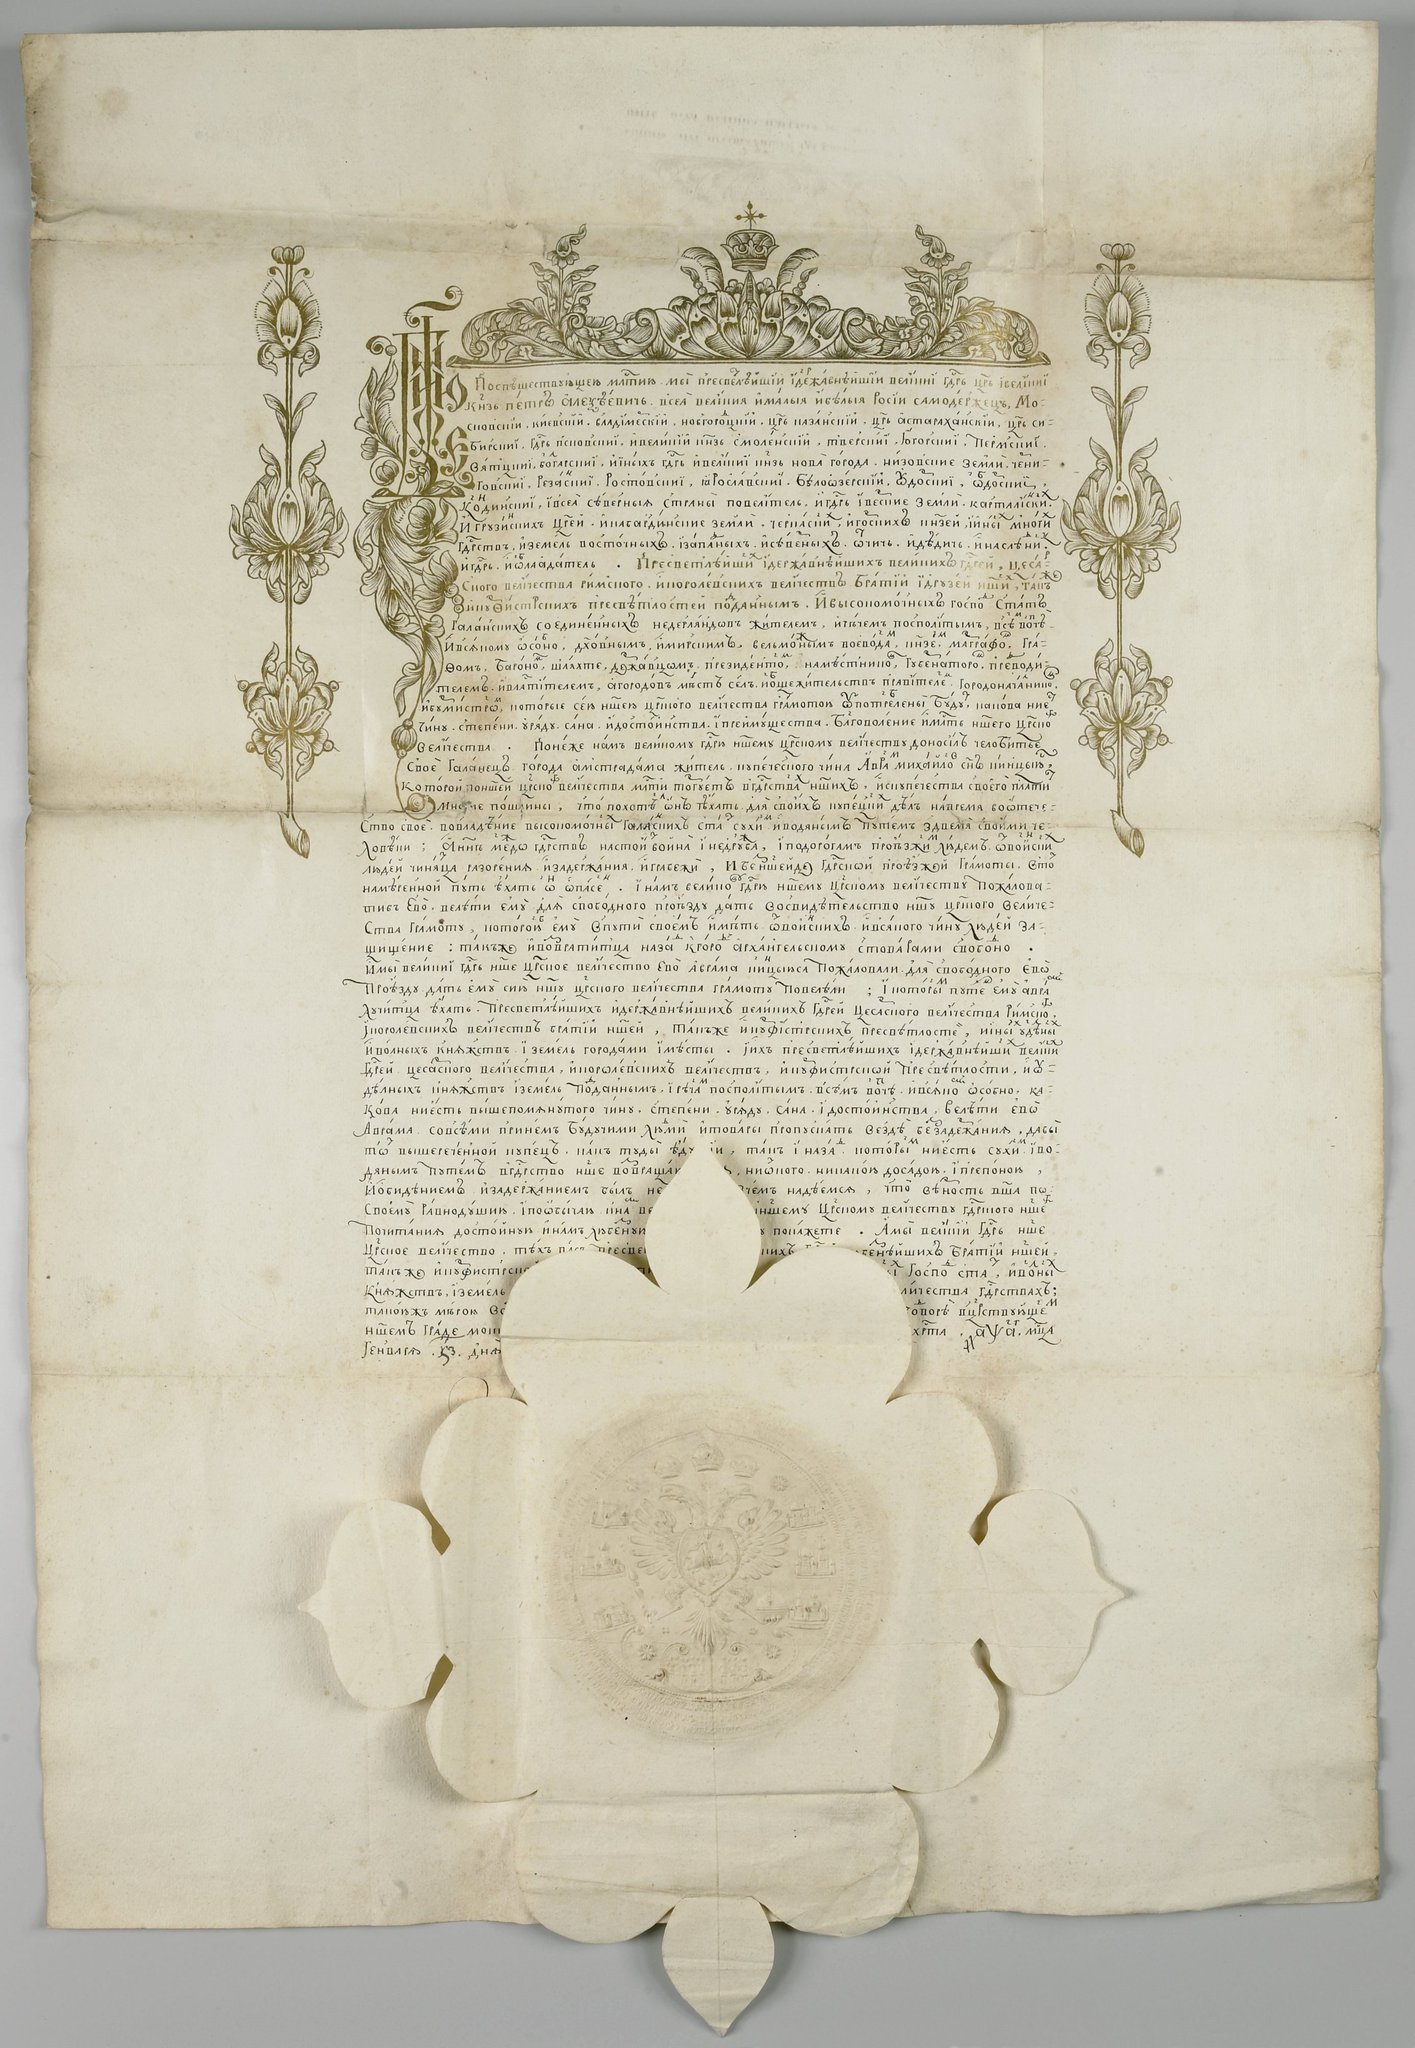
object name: charter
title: Oorkonde van Tsaar Peter I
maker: Anonymous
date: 1701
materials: ink, paper, wax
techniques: printing, writing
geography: russia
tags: peter i de grote (tsaar van rusland), amsterdam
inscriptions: date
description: Oorkonde van Tsaar Peter I de Grote bestaande uit twee vellen met een grote lakzegel (zeer beschadigd). Een vel is in het Russisch en de ander een verklaring in Latijn. In de Latijnse tekst worden de volgende namen vermeld: Abraham Kintzius en Abraham Michaelis en de steden Amsterdam en Arkhangelsk. Het zegel is gestempeld tussen het Russische blad en een blad papier uitgeknipt in een ornamentale vorm. Hoewel de lakzegel zelf grotendeels in verdwenen is de voorstelling van de stempel in blinddruk in het papier goed te zien.